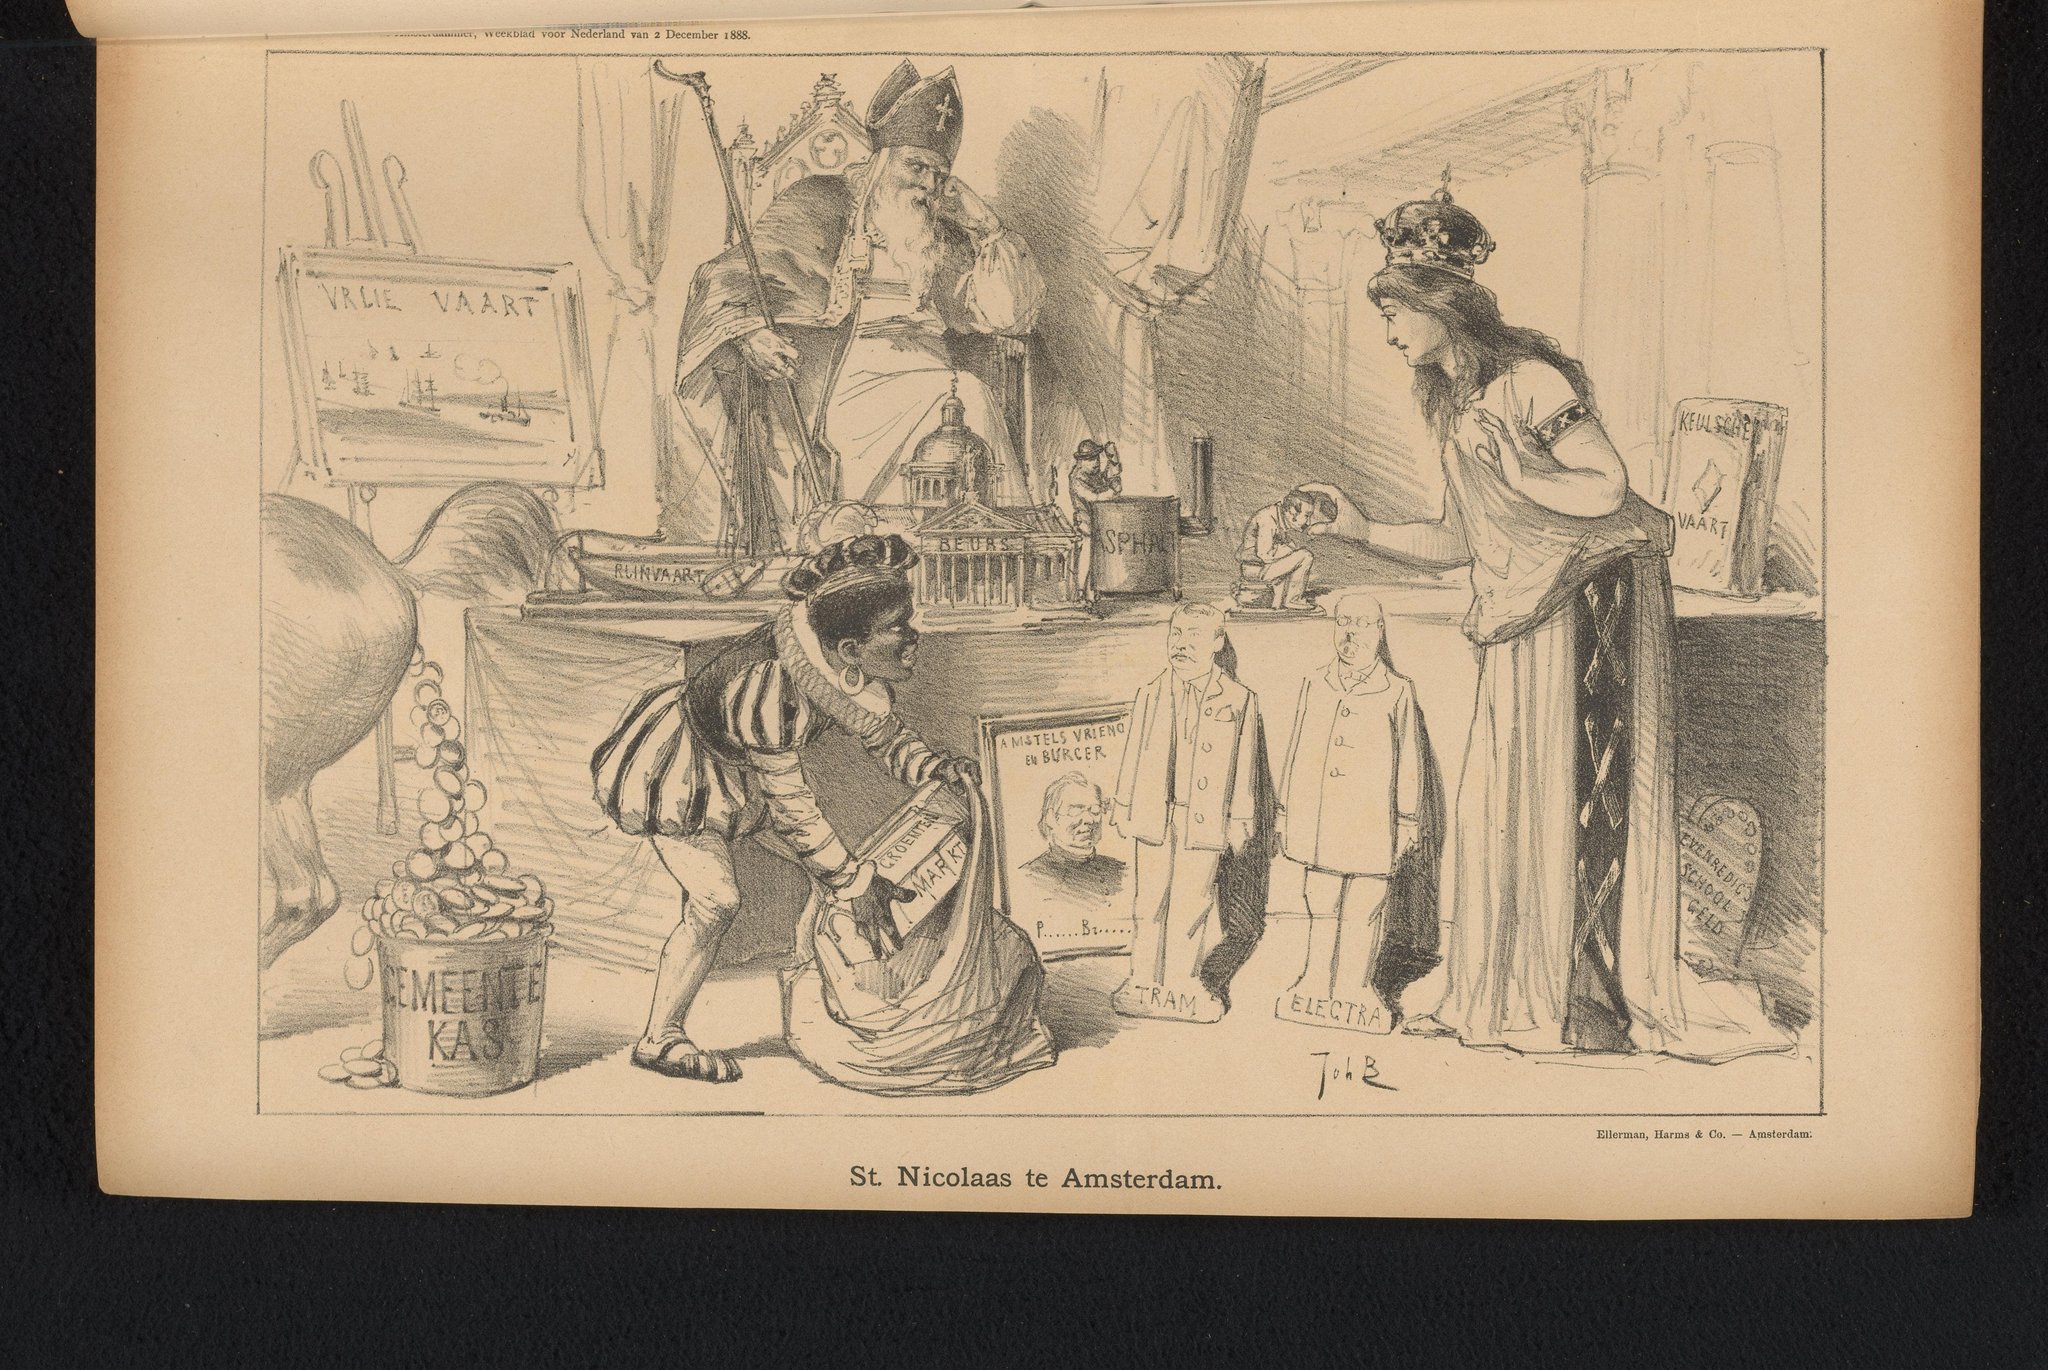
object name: cartoon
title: St. Nicolaas te Amsterdam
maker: johan braakensiek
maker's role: draughtsman, print maker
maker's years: 1858-1940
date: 1888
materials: paper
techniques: lithograph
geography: netherlands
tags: personification of a city, town-patron(ess), festivities on st. nicholas (eve) (december 5), municipal government, political caricatures and satires, amsterdam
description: St. Nicolaas zittend op een stoel boven een uitstalling van alle geschenken voor de stad Amsterdam. Rechts de stadsmaagd, links op de voorgrond haalt Zwarte Piet nog een cadeau uit de zak.